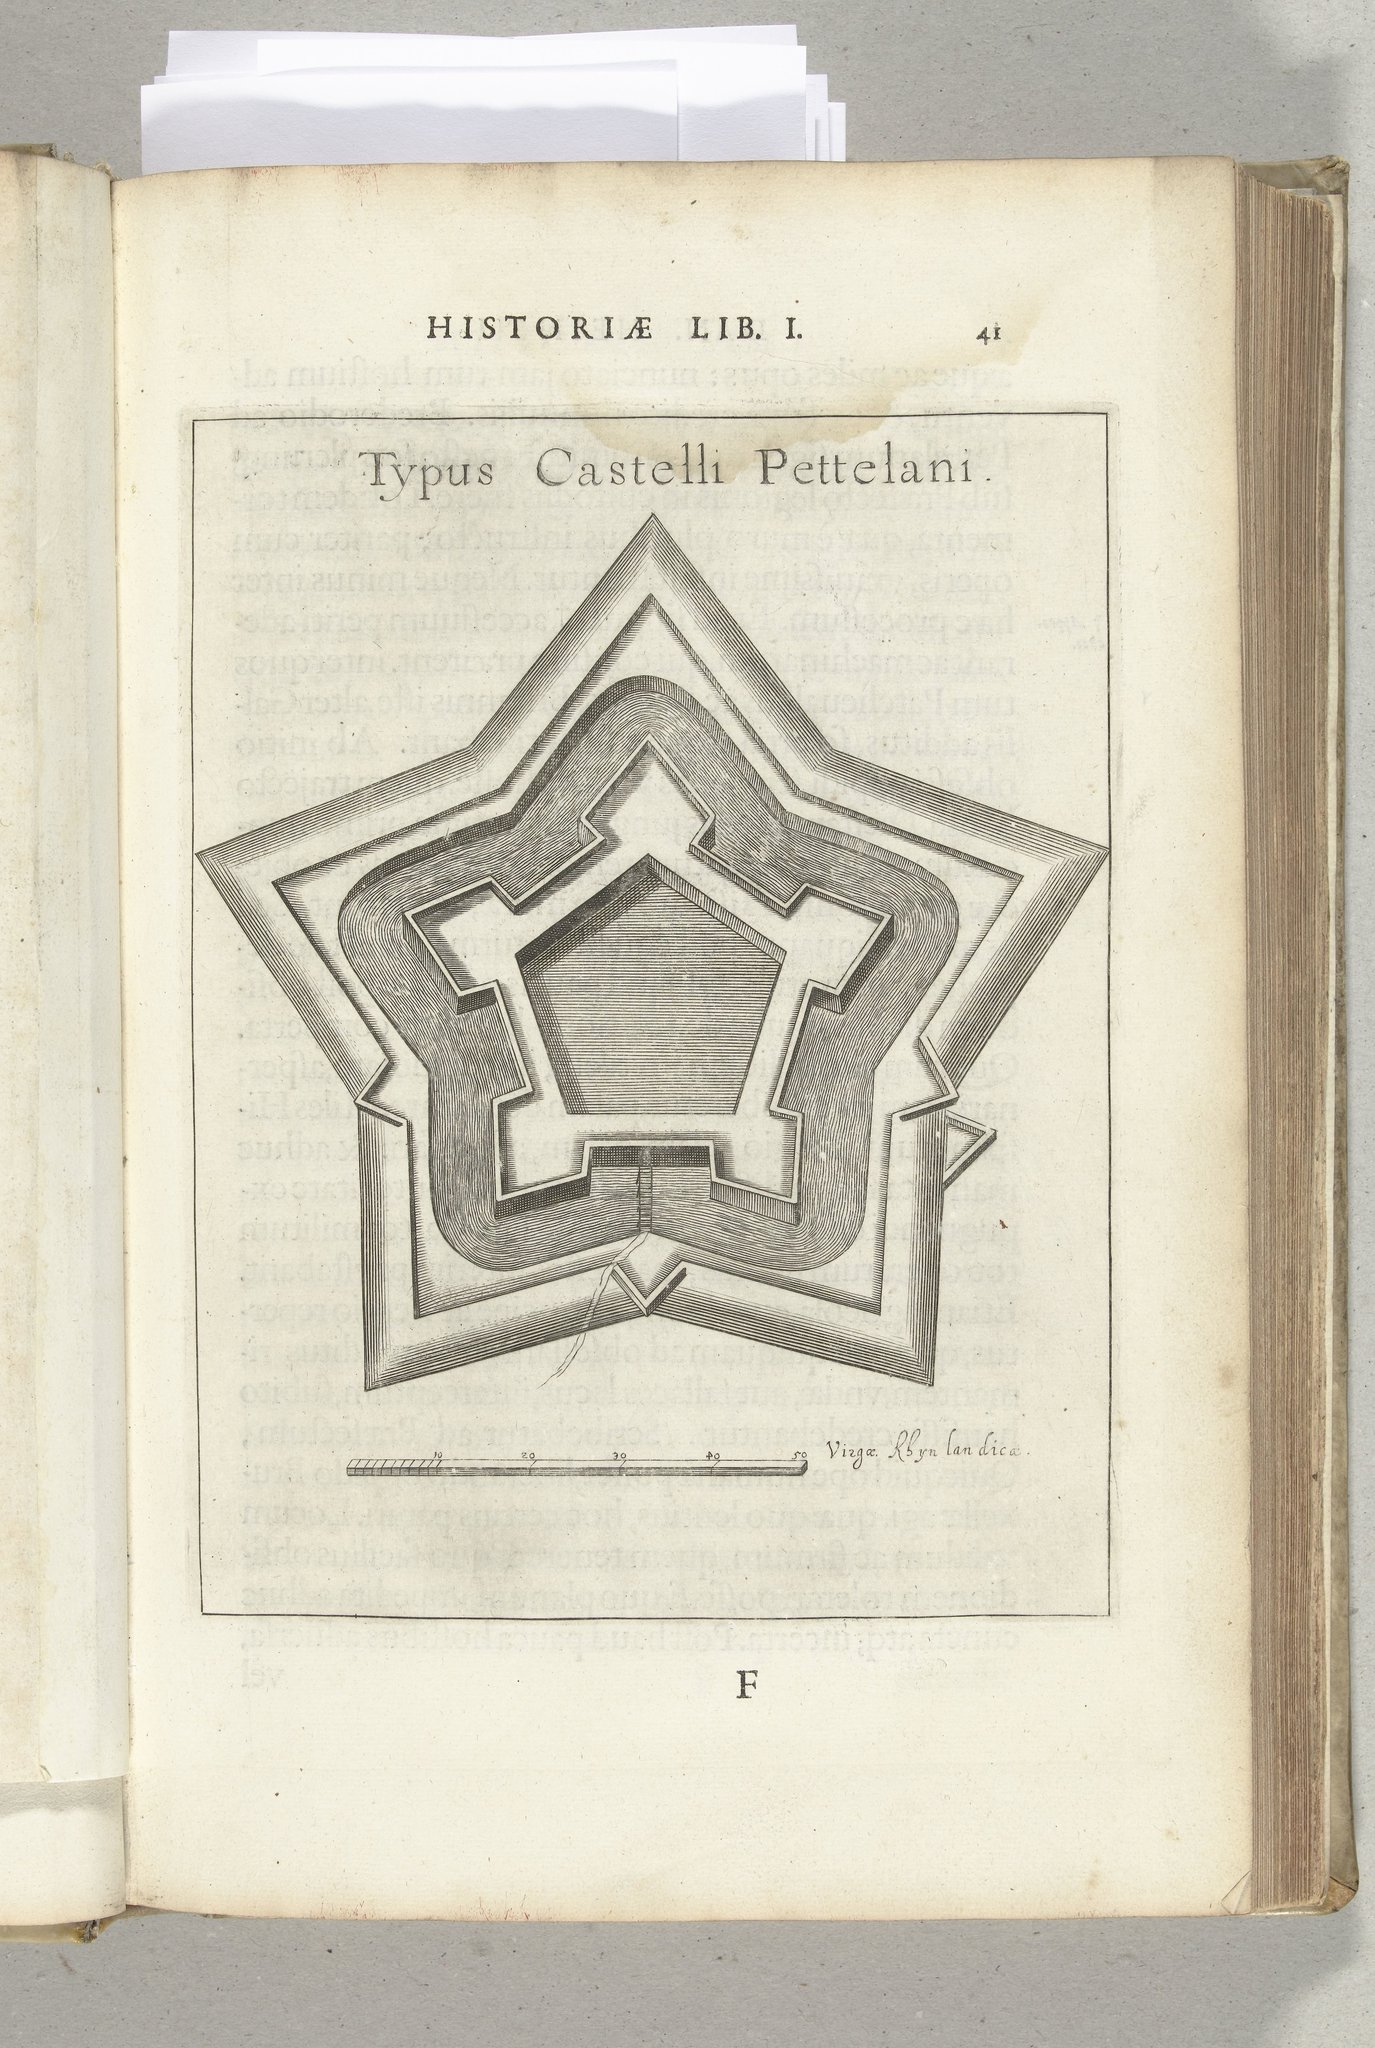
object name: print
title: Fort Pettelaer, 1629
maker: willem hondius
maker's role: print maker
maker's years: 1597-1660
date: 1629-1631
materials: paper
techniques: engraving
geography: northern netherlands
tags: delft, the hague, frederick henry (prince of orange), maps of separate countries or regions, fortifications, military engineering, den bosch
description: Illustratie in: Daniel Heinsius, Rerum ad Sylvam-Ducis atque alibi in Belgio aut a Belgio anno 1629 gestarum historia, Ex Officina Elzeviriorum, Leiden 1631, p. 41. In het exemplaar in de Rijksmuseum Research Library, signatuur 327 I 25.